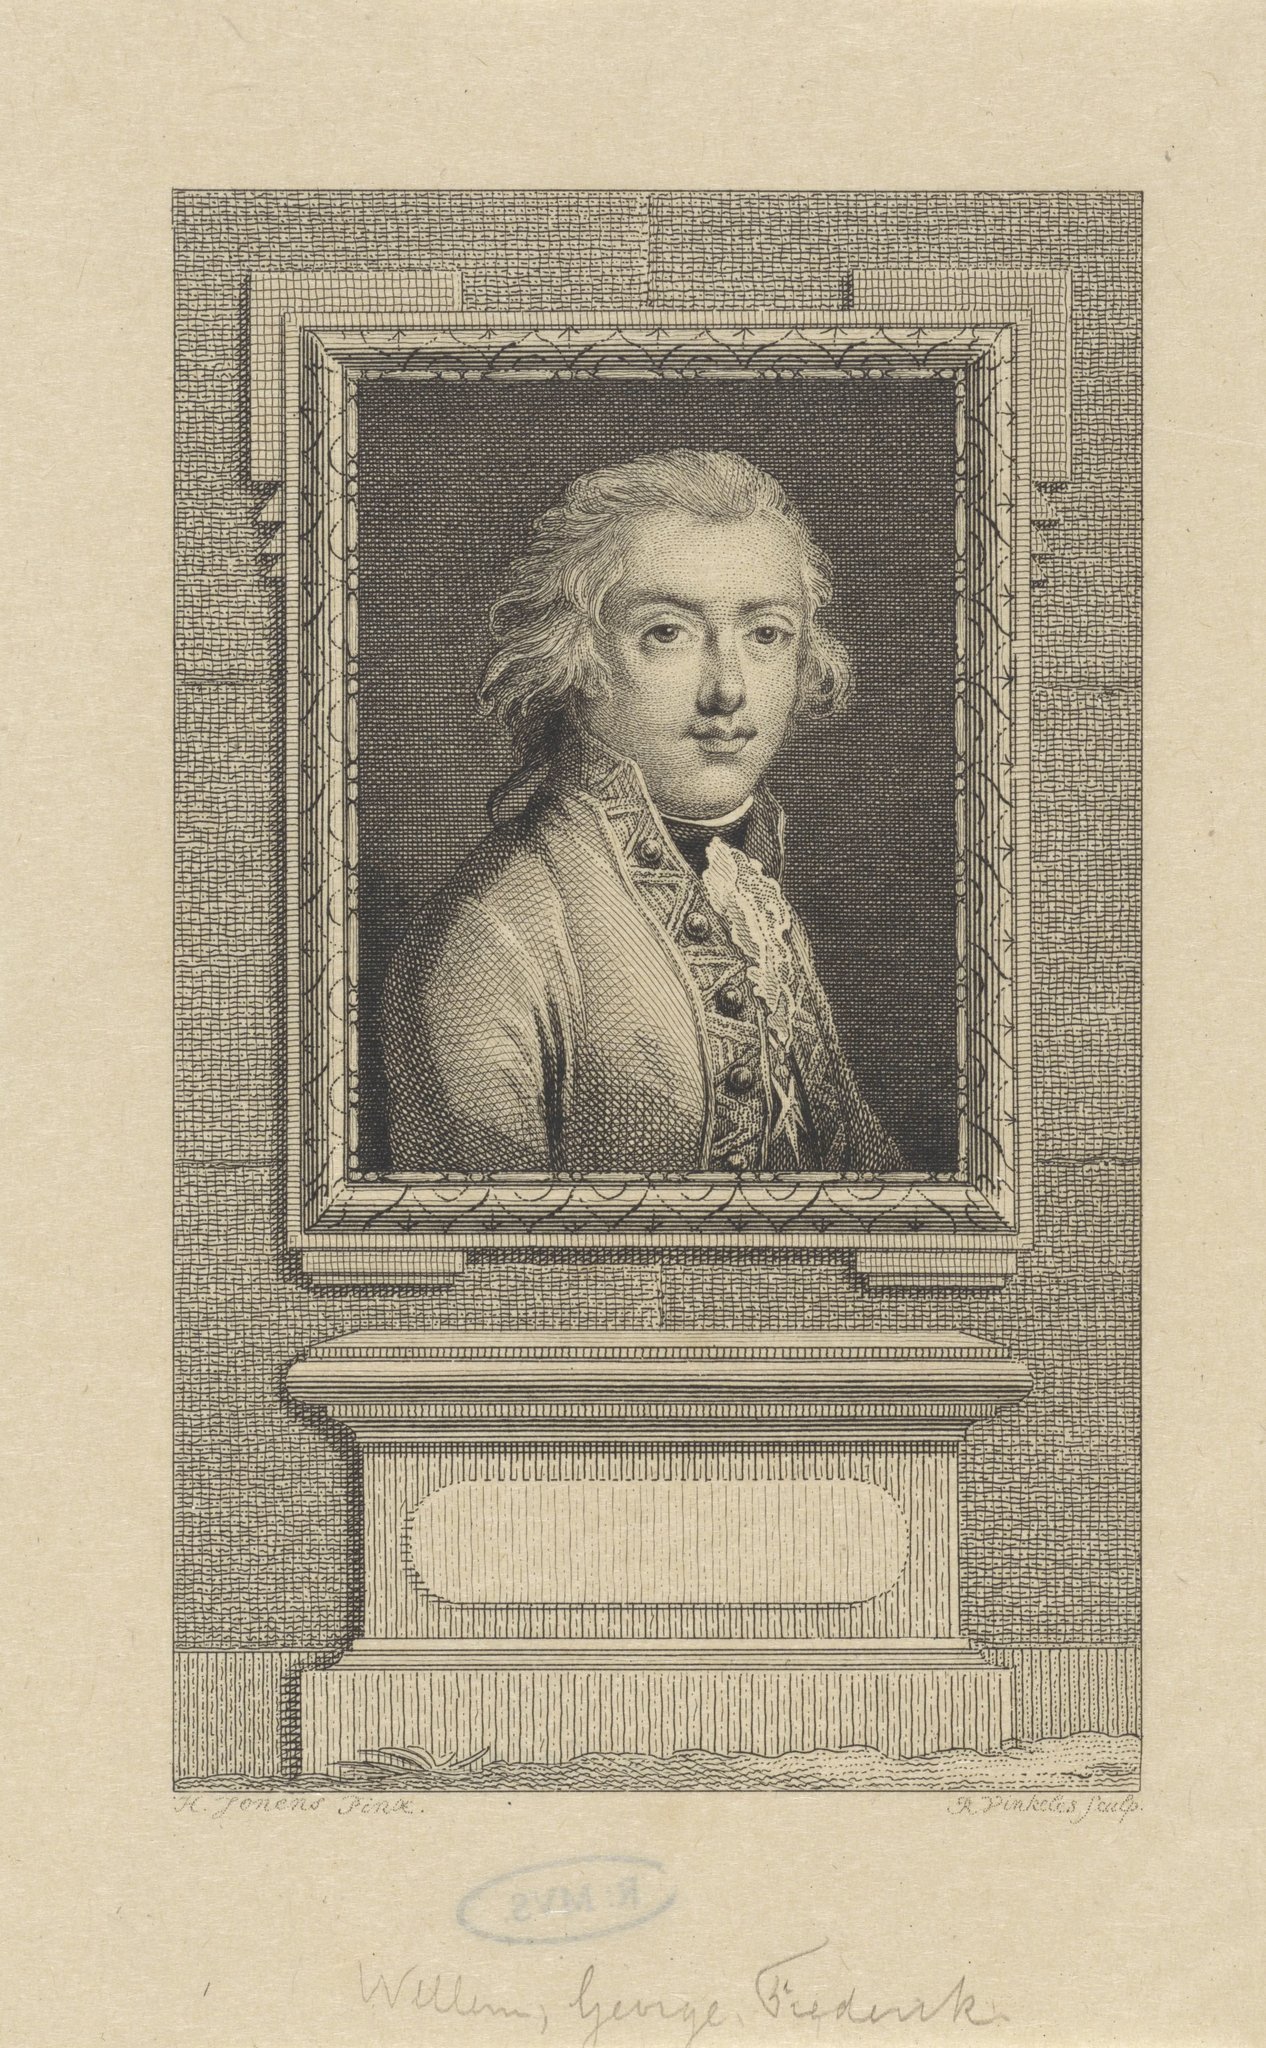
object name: print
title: Portret van Willem George Frederik, prins van Oranje-Nassau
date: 1786-1809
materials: paper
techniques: etching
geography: amsterdam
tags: the hague, willem george frederik (prins van oranje-nassau)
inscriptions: collector's mark: Lugt 2228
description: Latere staat prent gebruikt als boekillustratie in: Wagenaar, Jan. Vaderlandsche historie, (...) ten vervolge van Wagenaars Vaderlandsche historie. Dl. 1-43. Amsterdam: Johannes Allart, 1786-1809.